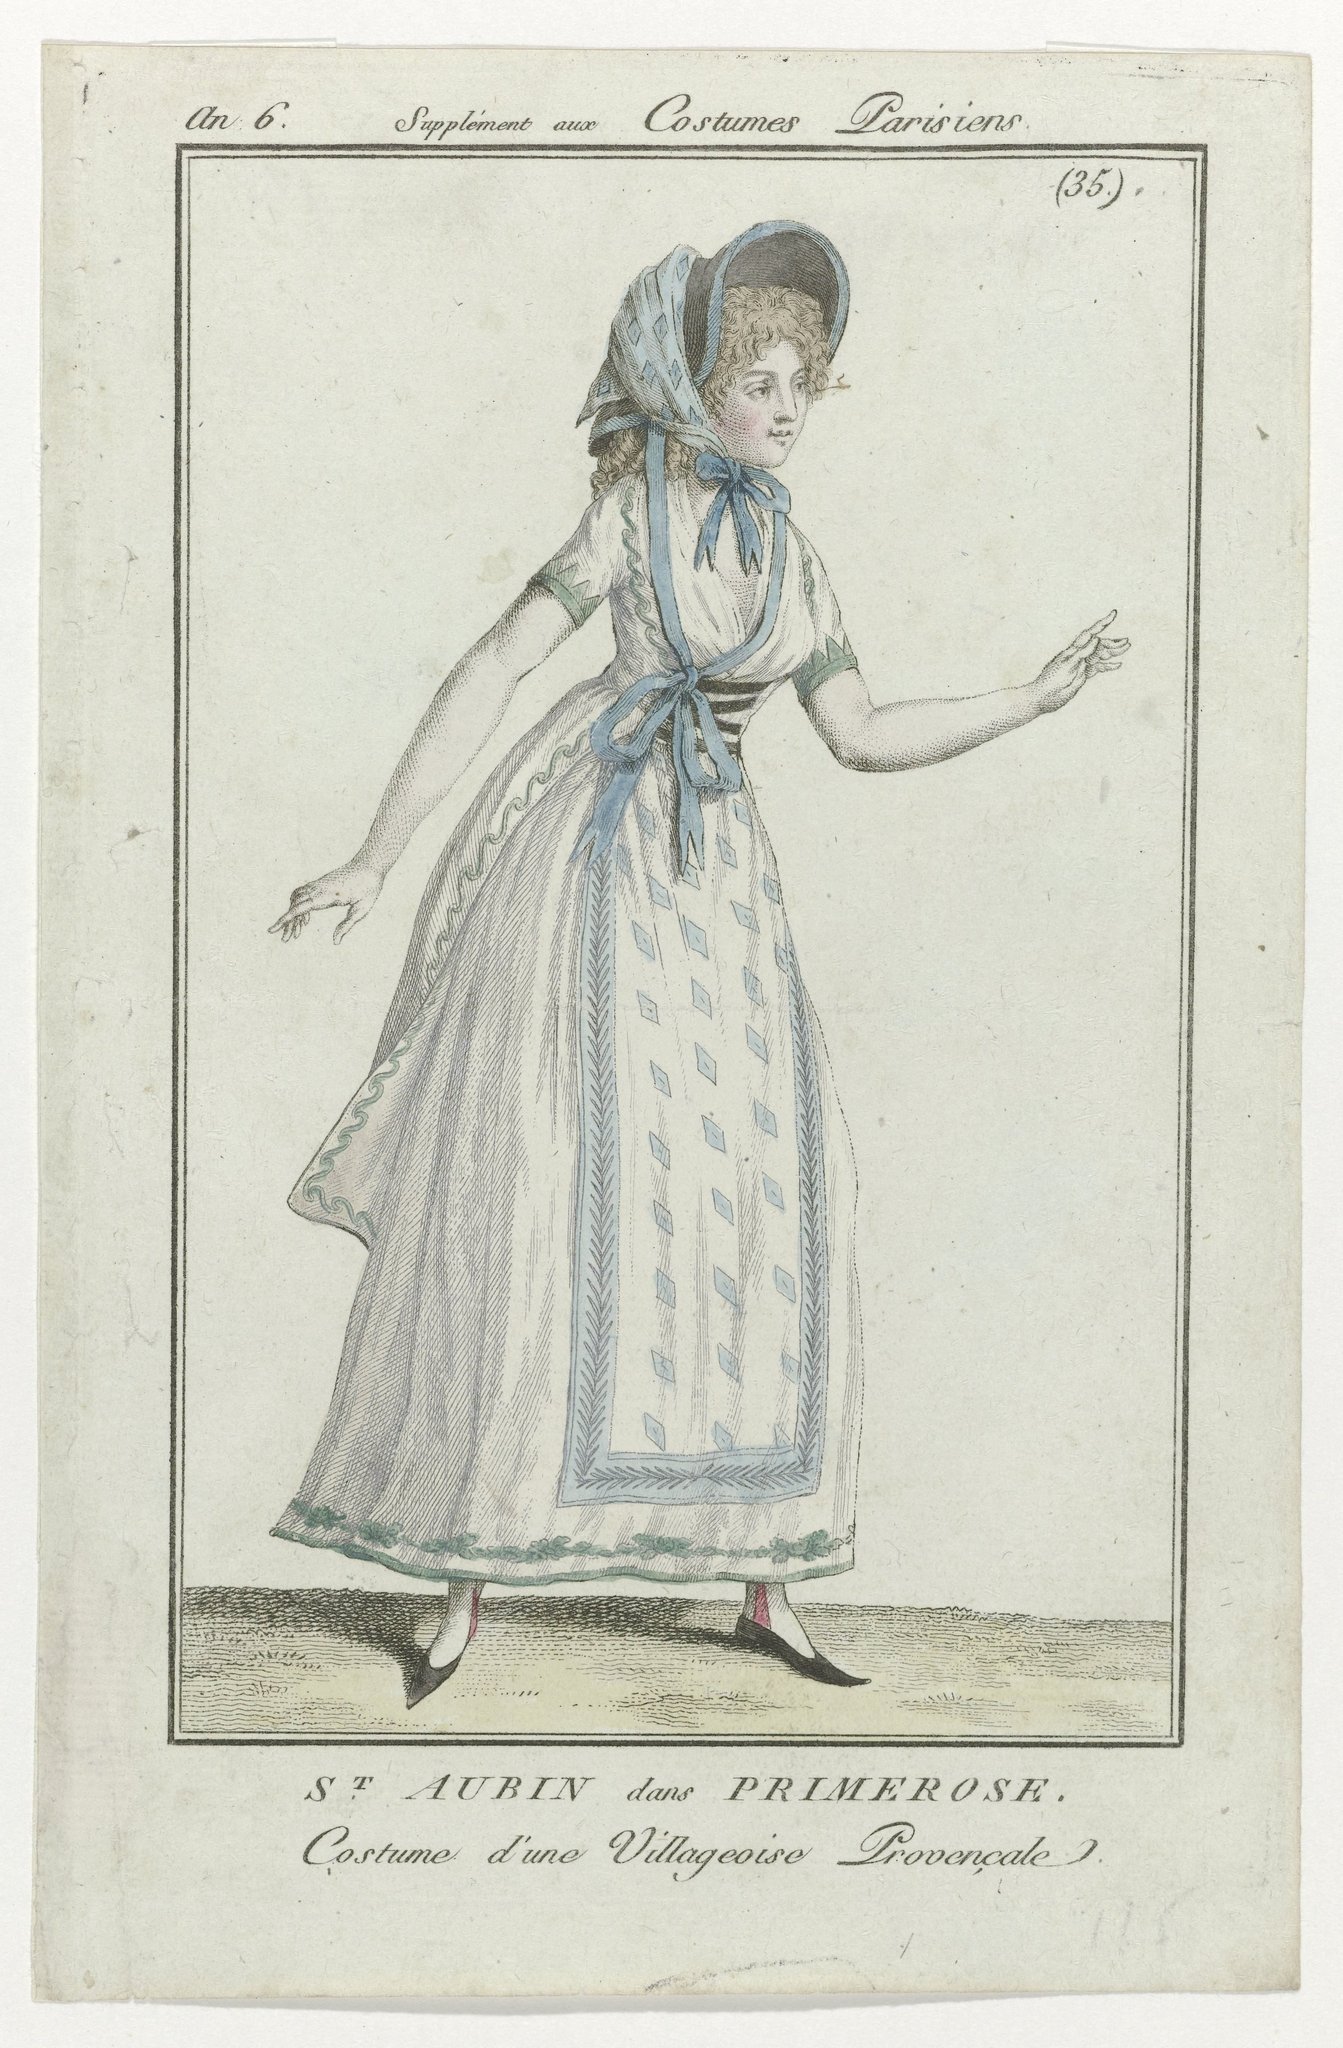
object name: fashion print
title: Journal des Dames et des Modes, Supplément aux Costume Parisien, 11 mai 1798, An 6, (35) : St Aubin dans Primeros (...)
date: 1798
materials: paper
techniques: engraving, hand coloring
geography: paris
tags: clothing for the upper part of the body (+ women's clothes), head-gear (+ women's clothes), fashion plates, shoes, sandals (+ women's clothes), dress, gown (+ women's clothes), stockings, socks (+ women's clothes), apron (+ women's clothes)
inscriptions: caption: ‘St Aubin dans Primerose. Costume d'une Villageoise Provençale.’, title: ‘Supplément aux Costumes Parisiens.’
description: Kostuum van een dorpeling uit de provincie: een tuniek (?) met korte mouwen, op een rok met (sier)schort met ruitpatroon. Hhoed met een gestrikt lint, waarover een doek met ruitpatroon, onder de kin vast gestrikt. Verdere accessoires: kousen, platte schoenen met puntige neuzen. De prent maakt deel uit van een supplement van het modetijdschrift Journal des Dames et des Modes, uitgegeven door Sellèque, Parijs, 1797-1839.